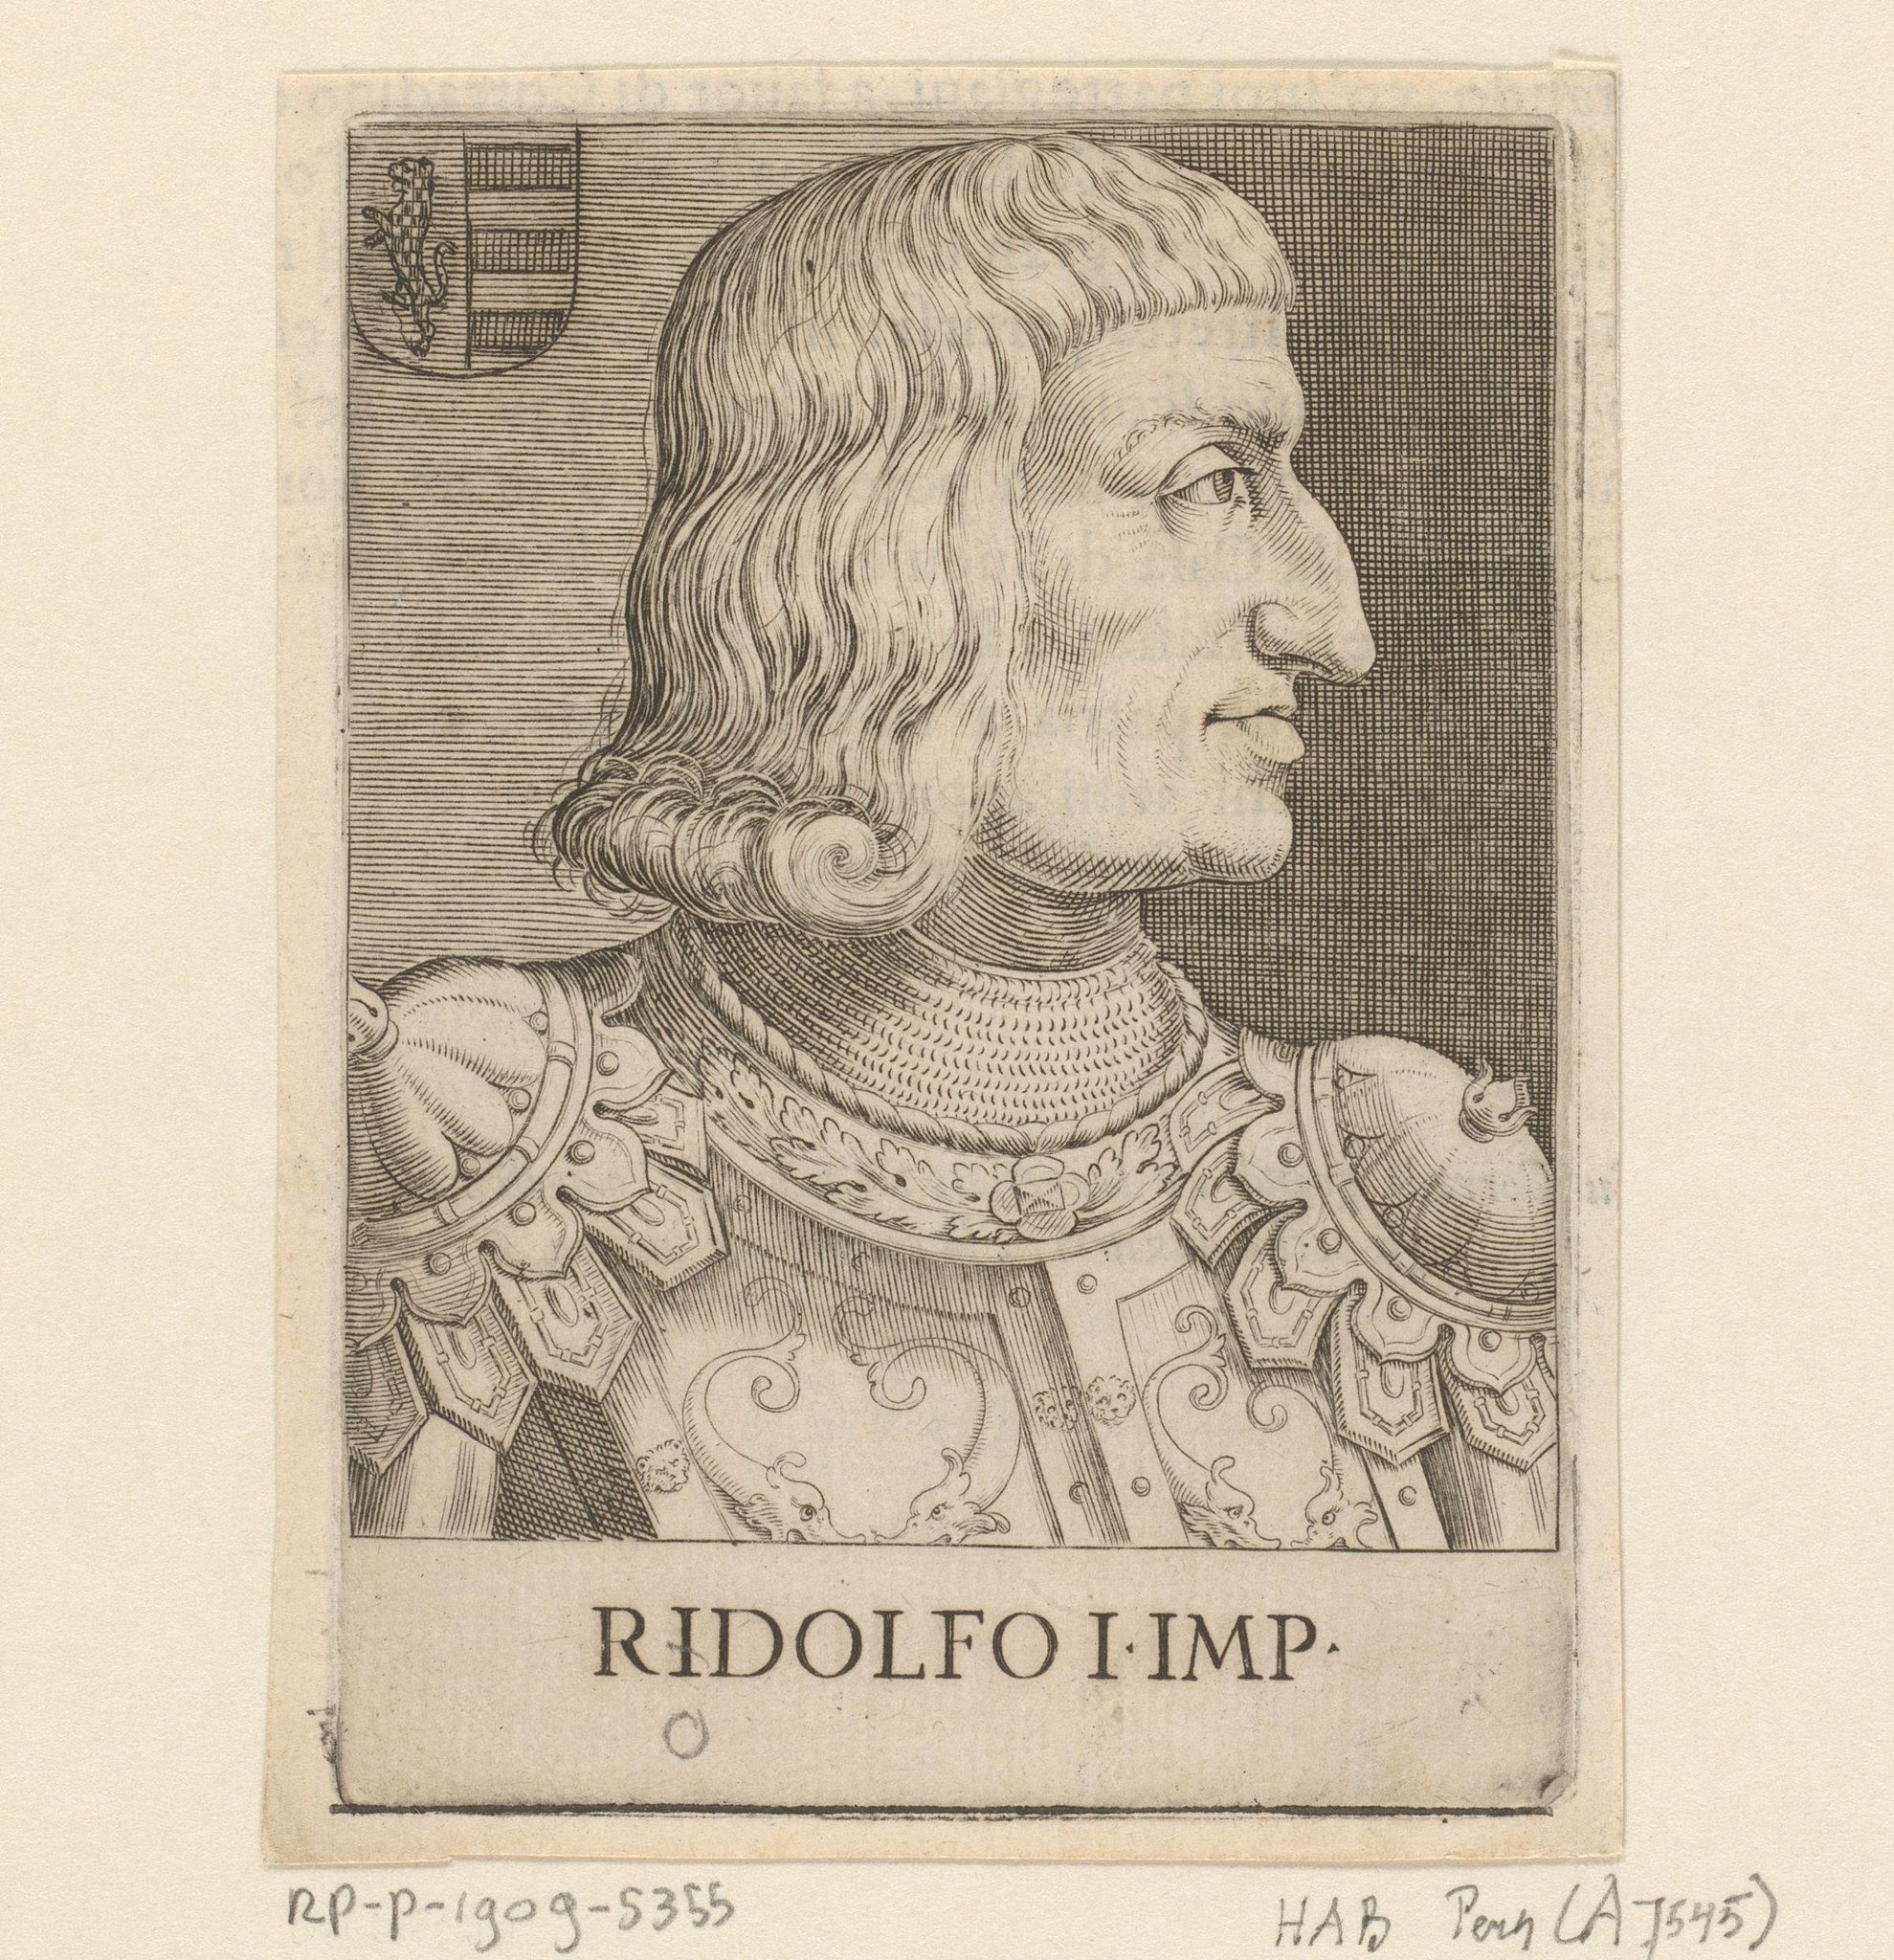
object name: book illustration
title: Portret van Rudolf I van Habsburg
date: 1546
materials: paper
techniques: engraving, letterpress printing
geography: rome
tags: historical persons, king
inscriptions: collector's mark: Lugt 2228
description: Prent uit: Ritratti et elogii di capitani Illustri. Che ne'secoli moderni hanno gloriosamente guerreggiato. Rome: Filippo de'Rossi en Vitale Mascardi, 1646, p. 24. Eerdere staten van prent ook gebruikt in: Ritratti et elogii di capitani Illustri. Rome: Pompilio Totti en Andrea Fei, 1635. En in: Ritratti di cento capitani illustri con li lor Fatti in guerra […], Rome: Domenico Gigliotti, 1596.